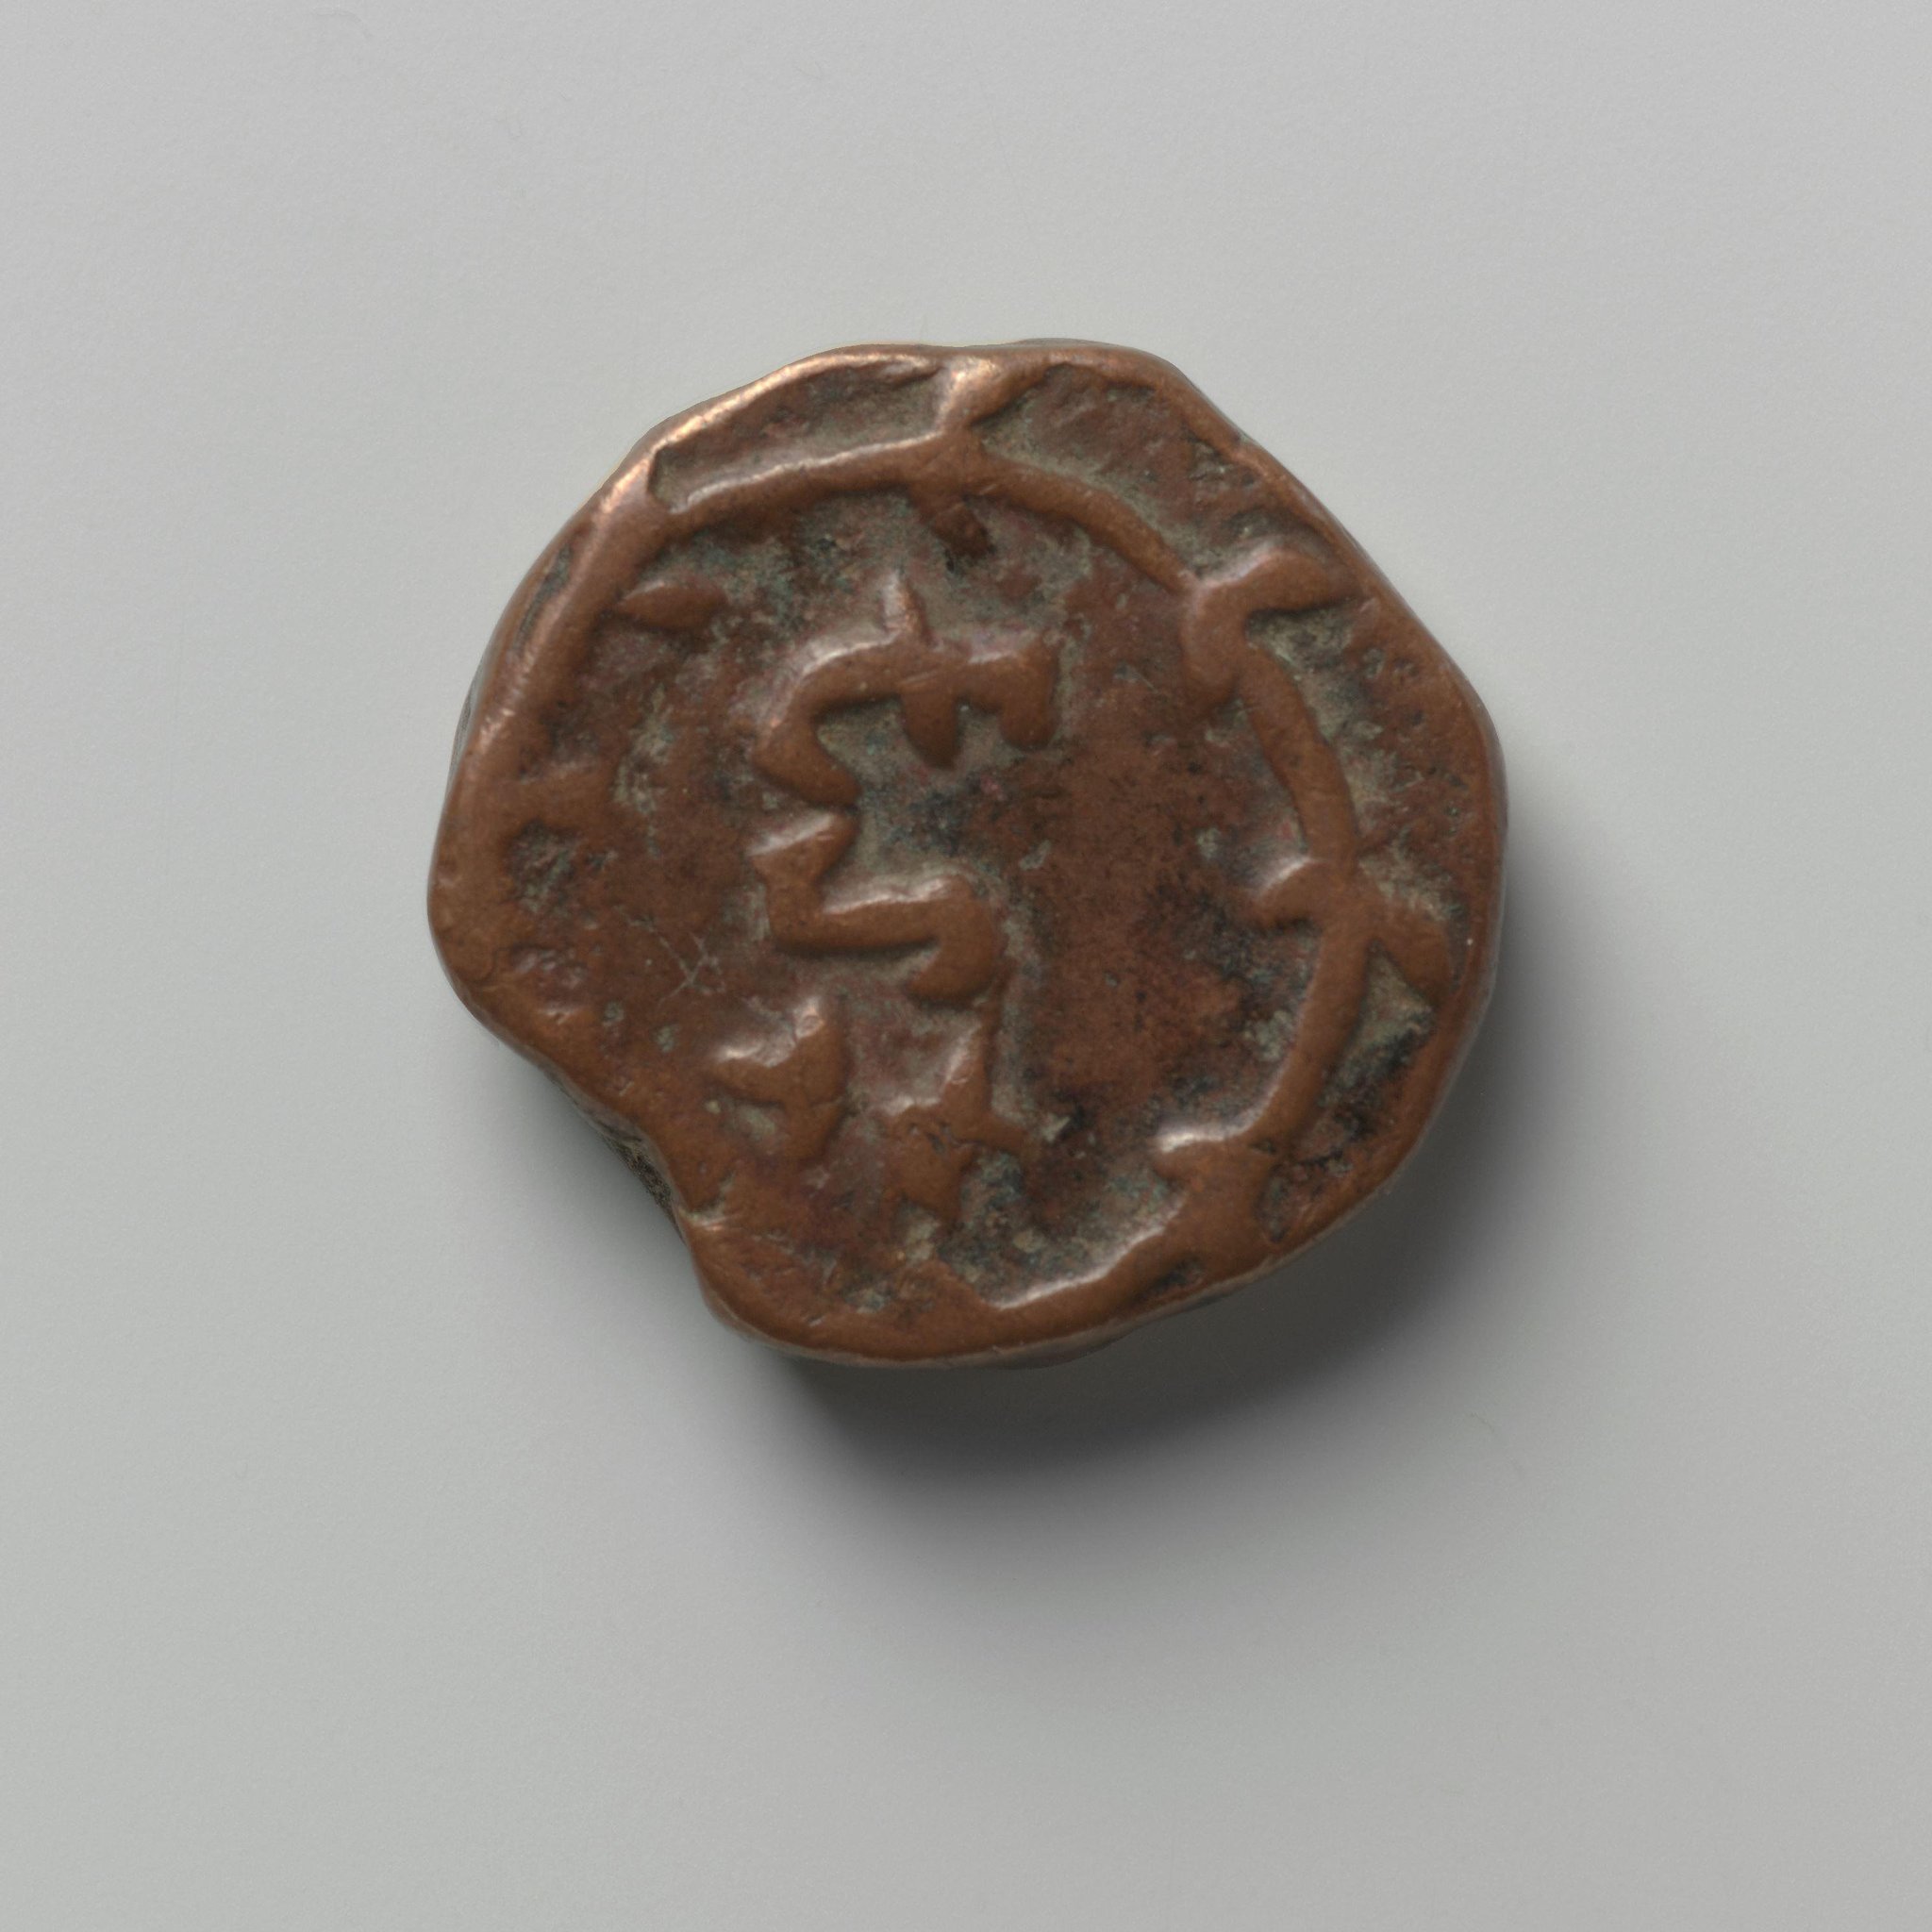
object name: coin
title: Ceylon, 1/4 kransstuiver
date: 1680-1710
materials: copper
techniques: striking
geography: jaffna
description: Koperen munt. Voorzijde: in een doornenkroon waarde-aanduiding 1/4 St (t omgekeeerd). Keerzijde: in een doornenkroon waarde-aanduiding 1/4 St (t omgekeerd). Gladde rand.